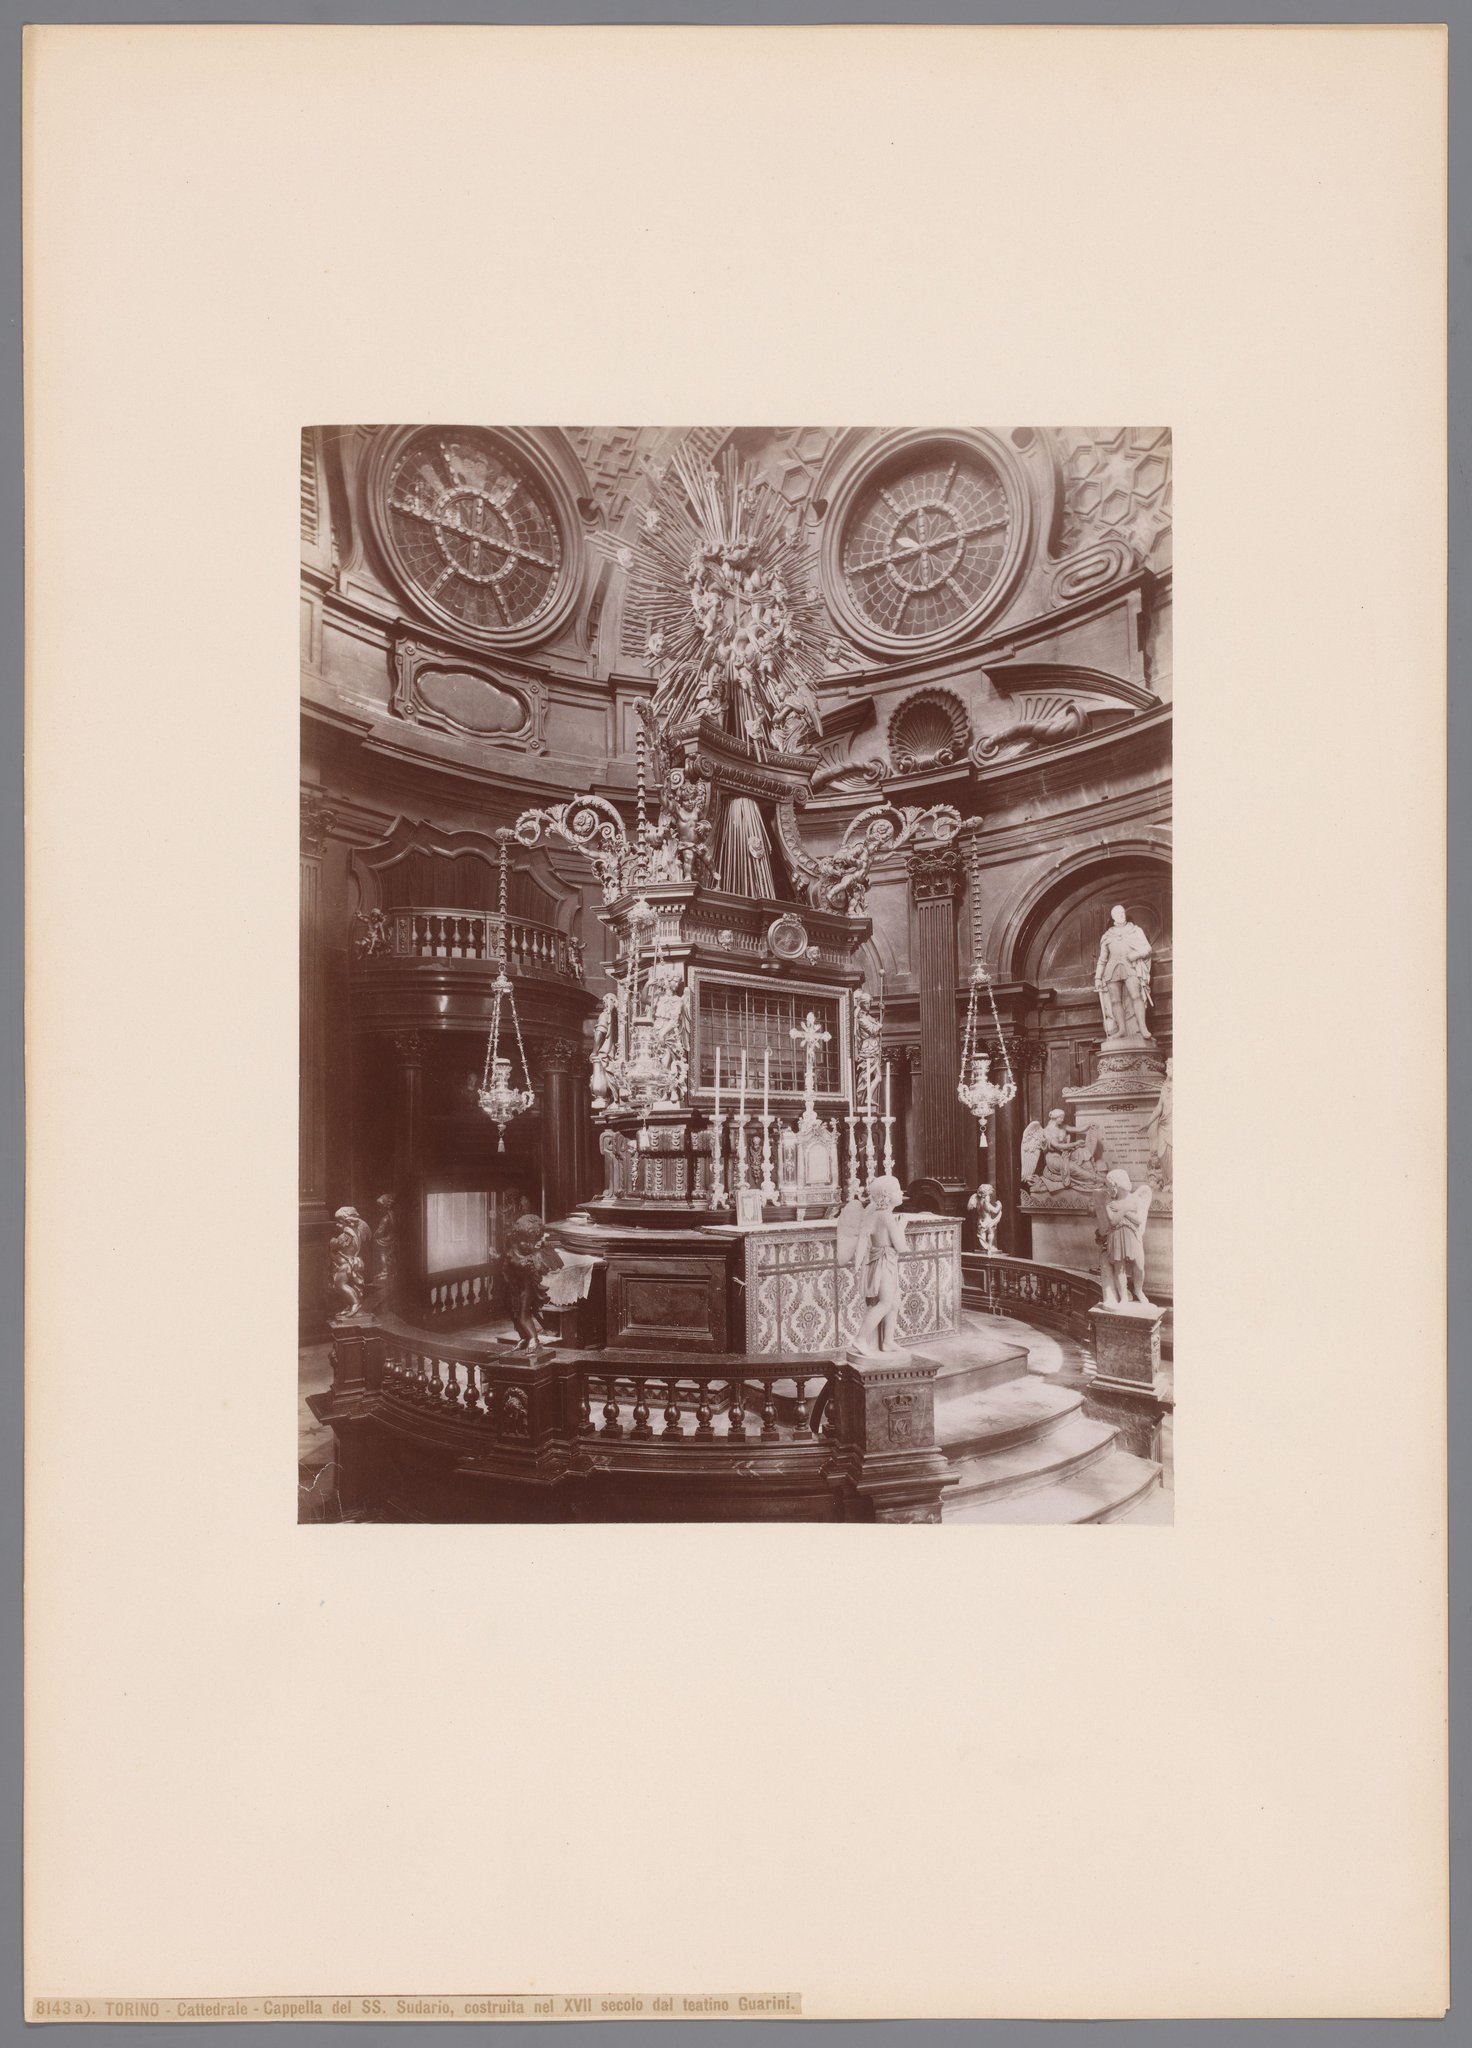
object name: photograph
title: Kapel in de kathedraal van Turijn, Italië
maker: giacomo brogi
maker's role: fotograaf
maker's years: 1822-1881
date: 1864-1881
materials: cardboard, paper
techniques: albumen print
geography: florence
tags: altar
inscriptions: number: ‘8143a).’, number: ‘15’